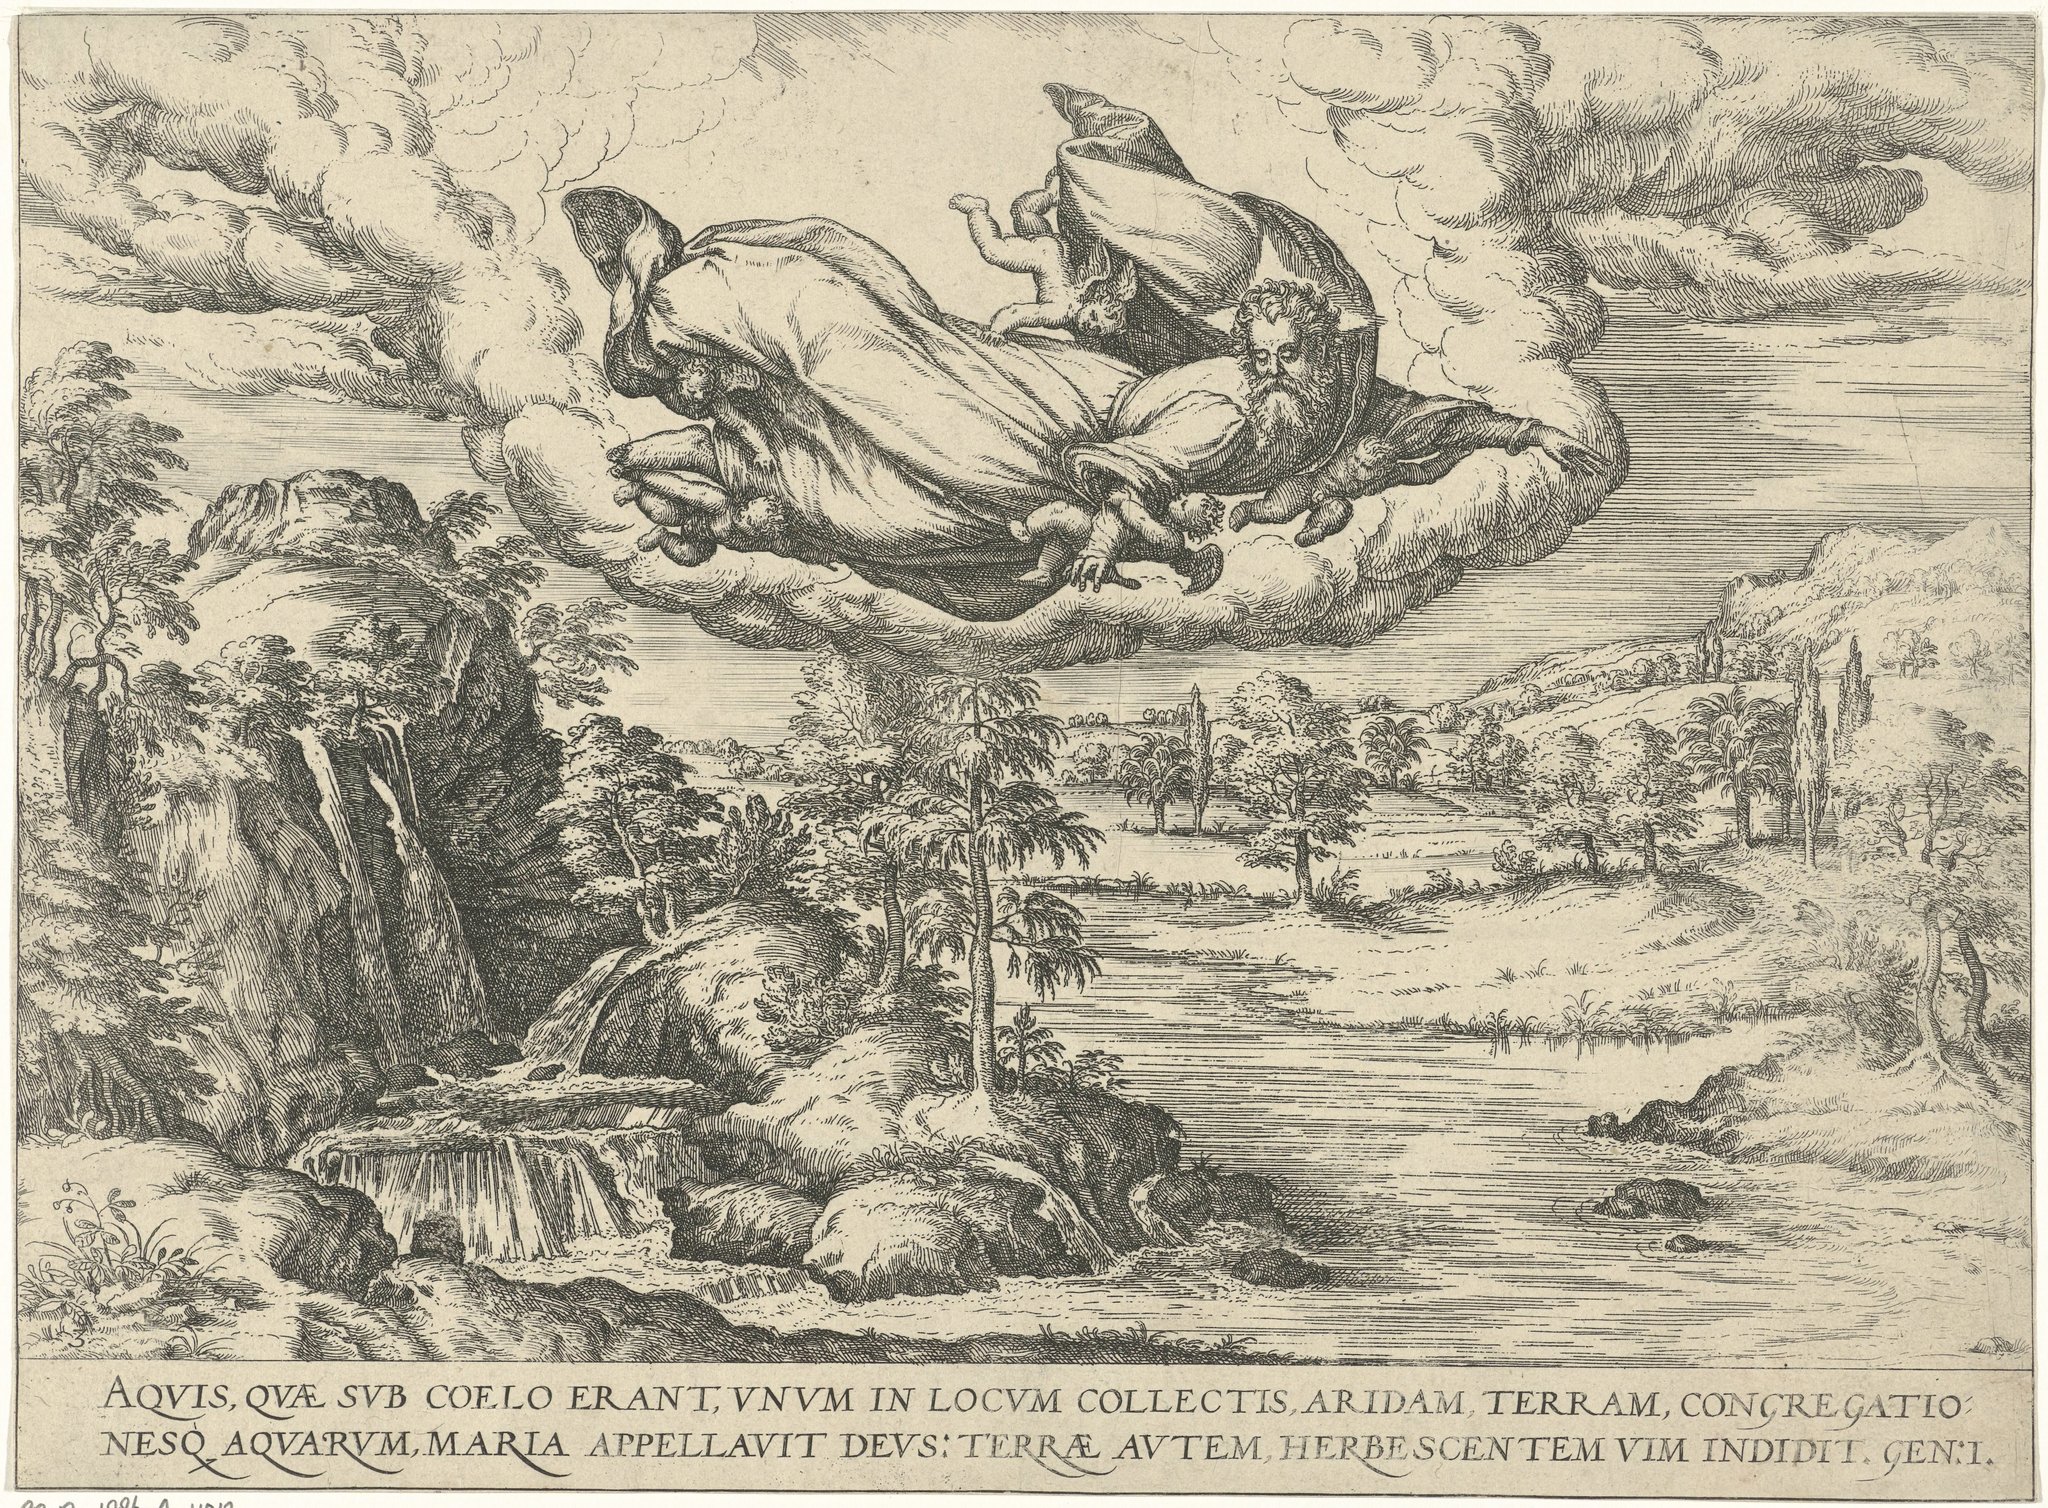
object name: print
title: Figurae et imagines bibliorum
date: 1577-1627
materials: paper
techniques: etching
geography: cologne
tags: god the creator, gathering of the waters below the firmament; dry land appears and produces all kinds of plants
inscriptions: collector's mark: Lugt 2228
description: God, gedragen door engelen, schept land en water en geeft deze een eigen plek. Onderaan een Bijbeltekst in het Latijn uit Gen. 1.